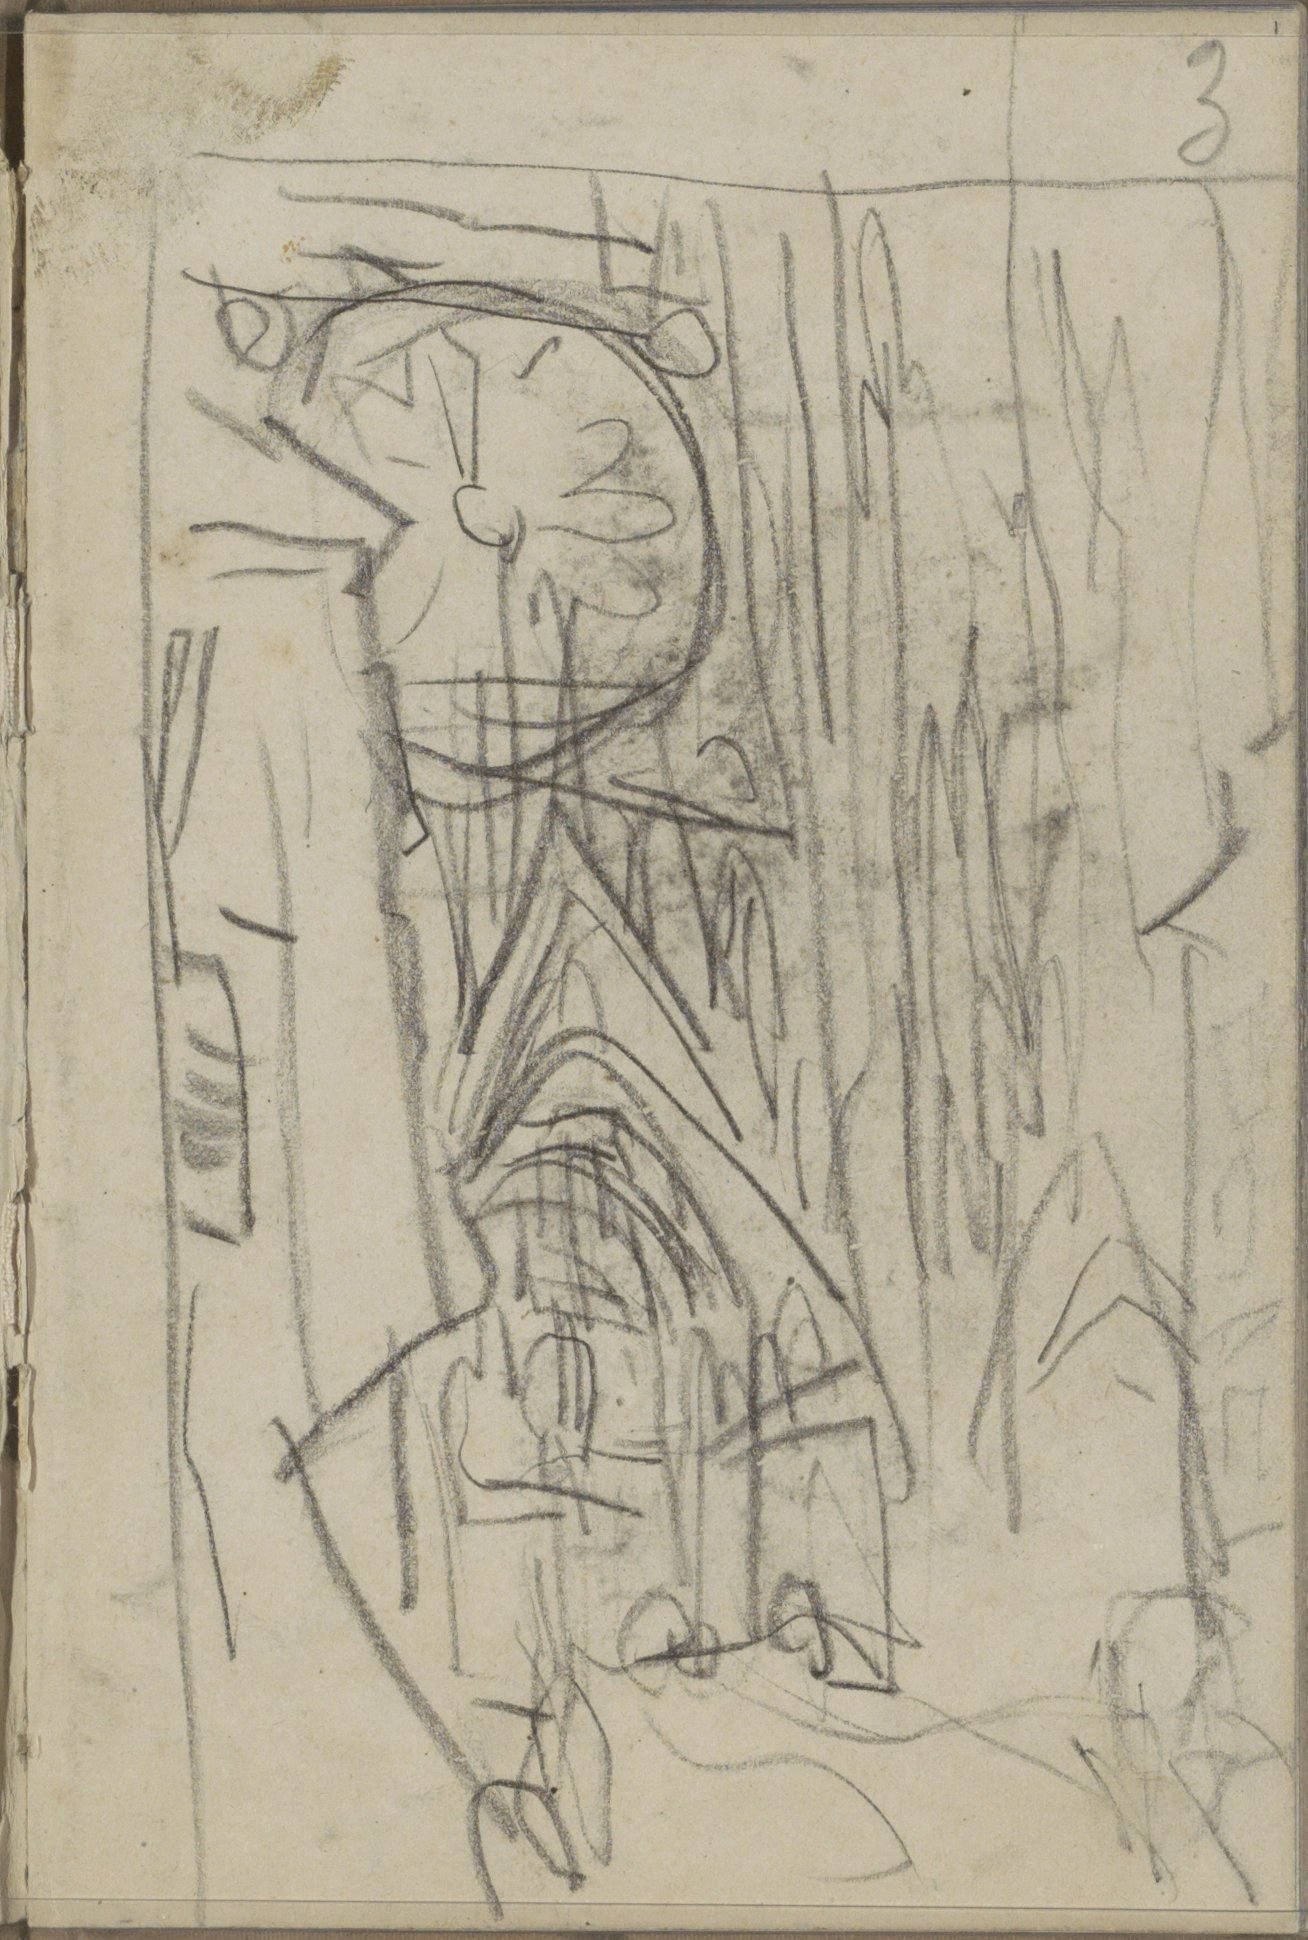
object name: sketchbook leaf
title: Architectuurstudie, vermoedelijk een kerk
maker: marius bauer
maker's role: draughtsman, print maker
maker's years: 1867-1932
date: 1888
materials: chalk, paper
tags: architecture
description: Pagina 1 uit een schetsboek met 49 bladen.